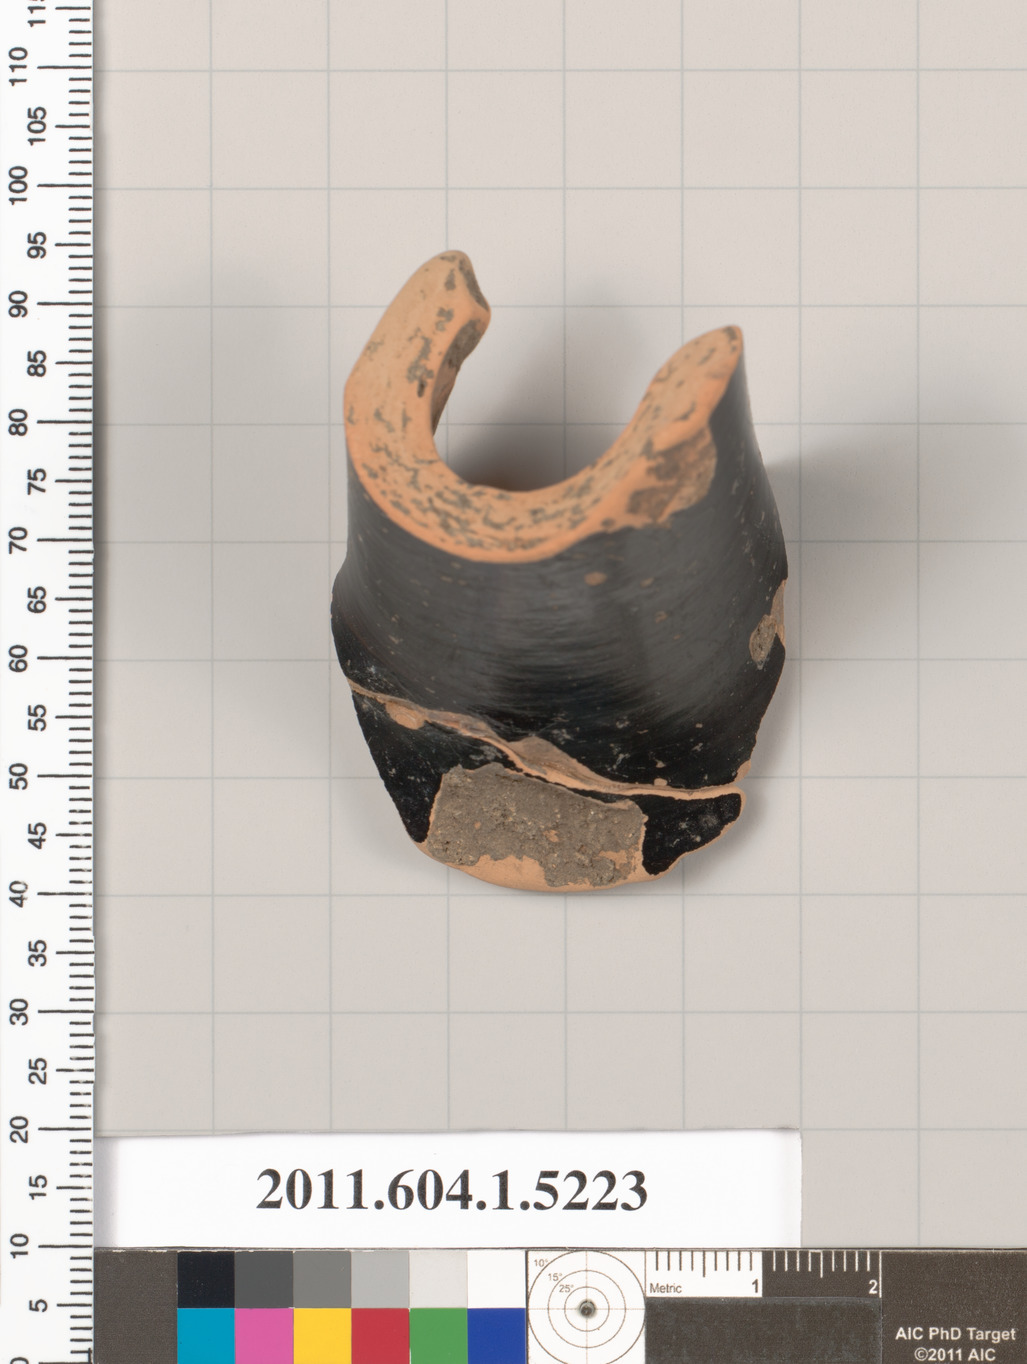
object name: kylix fragment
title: Terracotta fragment of a kylix (drinking cup)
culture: greek, attic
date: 534-501 BCE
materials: terracotta